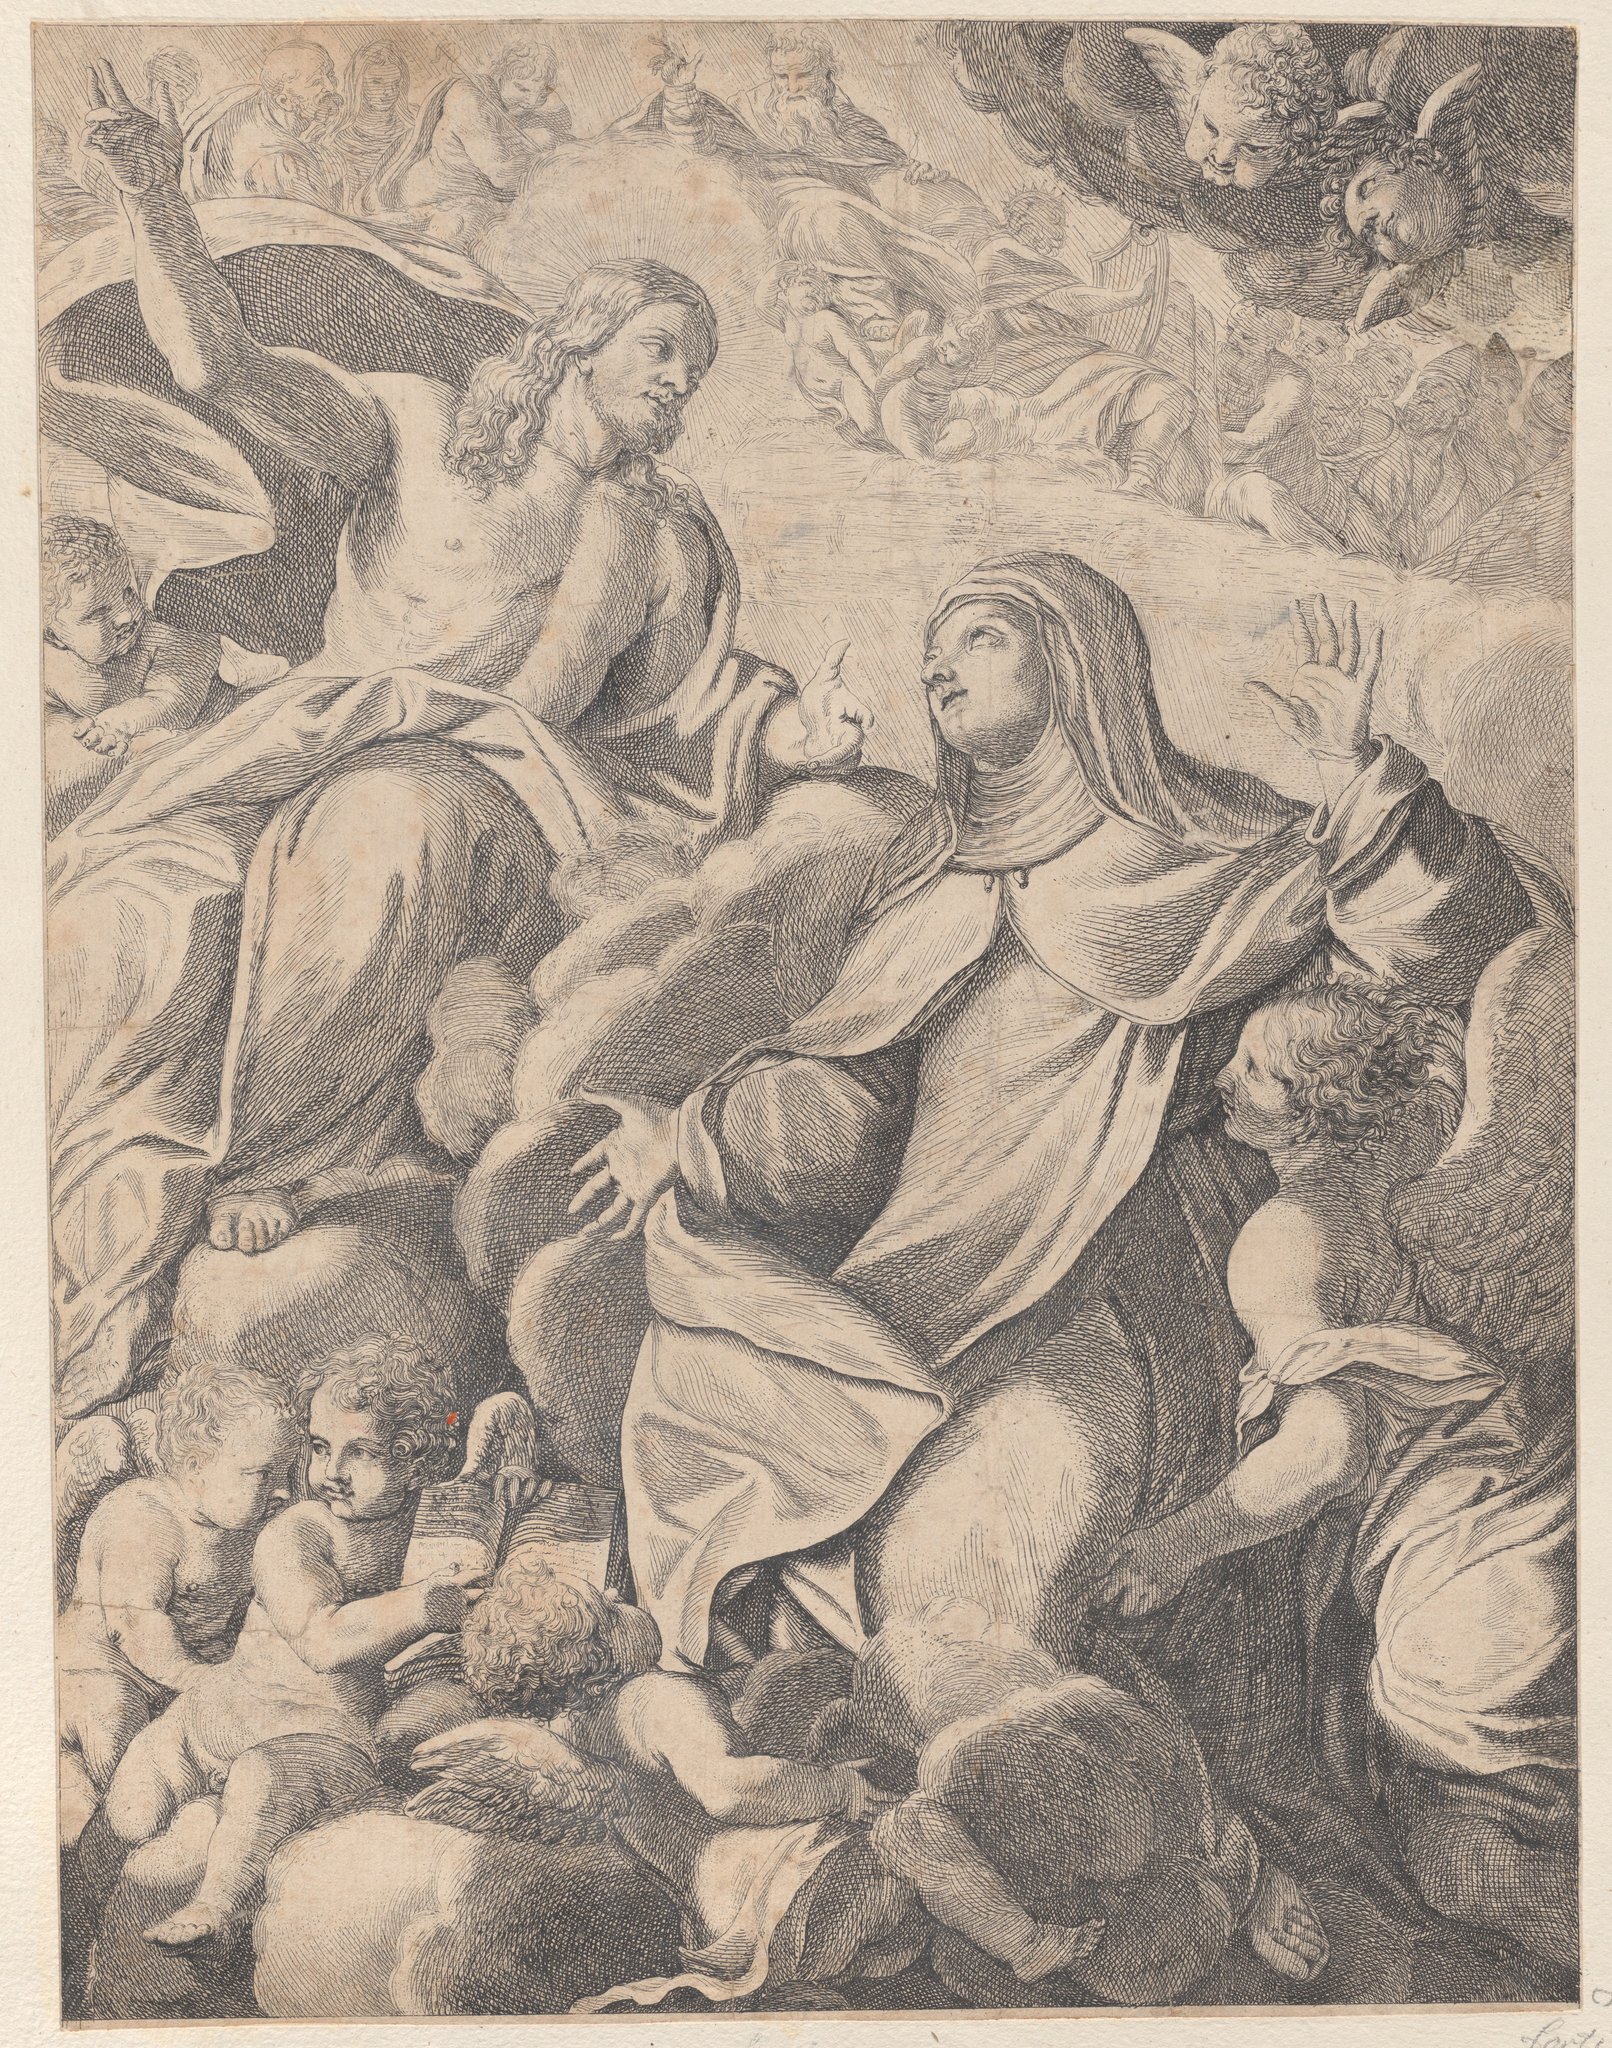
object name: print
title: Christ receiving the Virgin in heaven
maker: carlo antonio forti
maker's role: artist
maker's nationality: italian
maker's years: 1657-1732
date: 1677-1732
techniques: etching